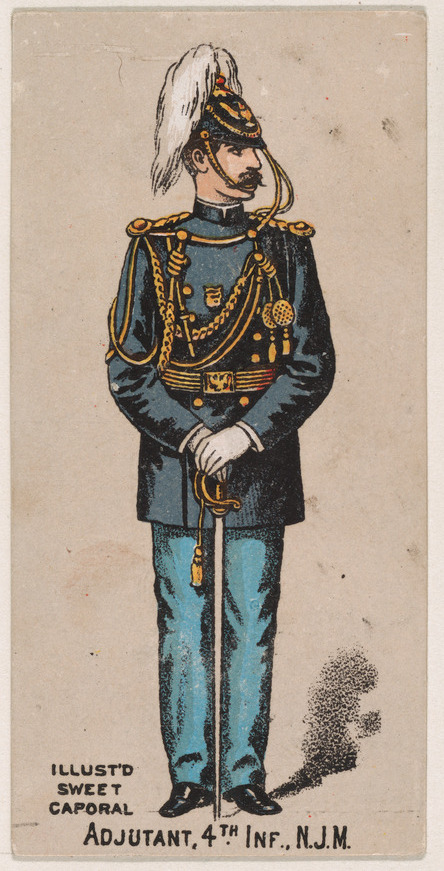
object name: print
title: Adjutant, 4th Infantry, New Jersey Militia, from the Military Series (N224) issued by Kinney Tobacco Company to promote Sweet Caporal Cigarettes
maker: kinney brothers tobacco company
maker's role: publisher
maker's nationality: american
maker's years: 1869-2011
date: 1888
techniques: color lithograph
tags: military,swords,men,profiles